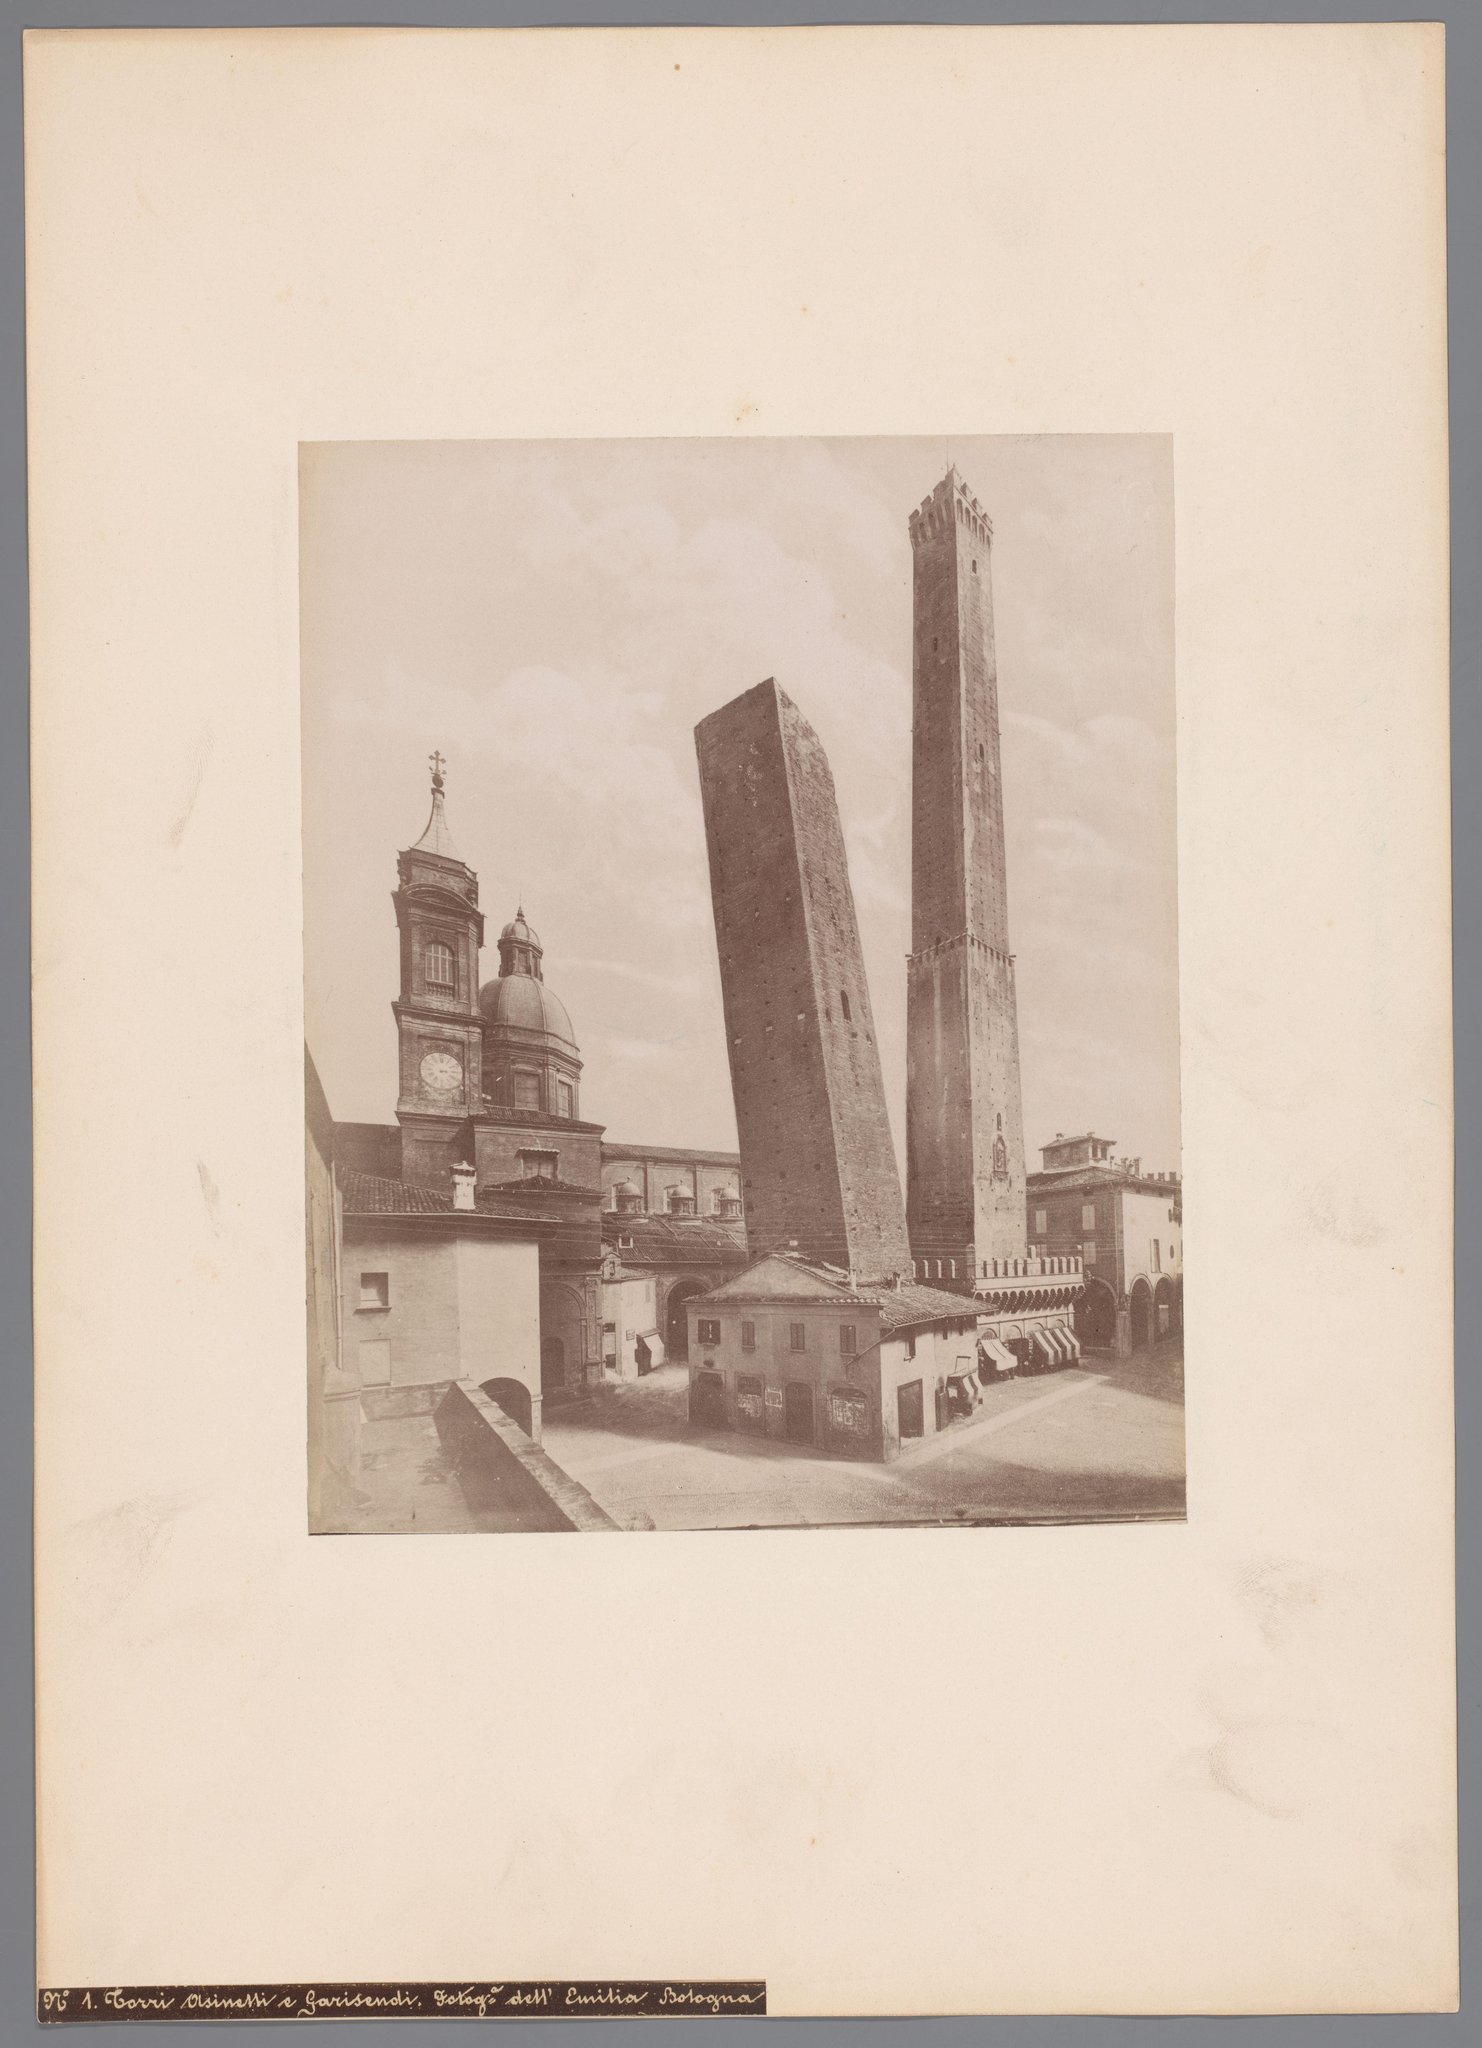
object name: photograph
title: Gezicht op de torens van Asinelli en Garisenda te Bologna, Italië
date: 1865-1907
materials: cardboard, paper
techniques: albumen print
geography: bologna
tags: piece of sculpture, reproduction of a piece of sculpture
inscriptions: number: ‘No. 1’